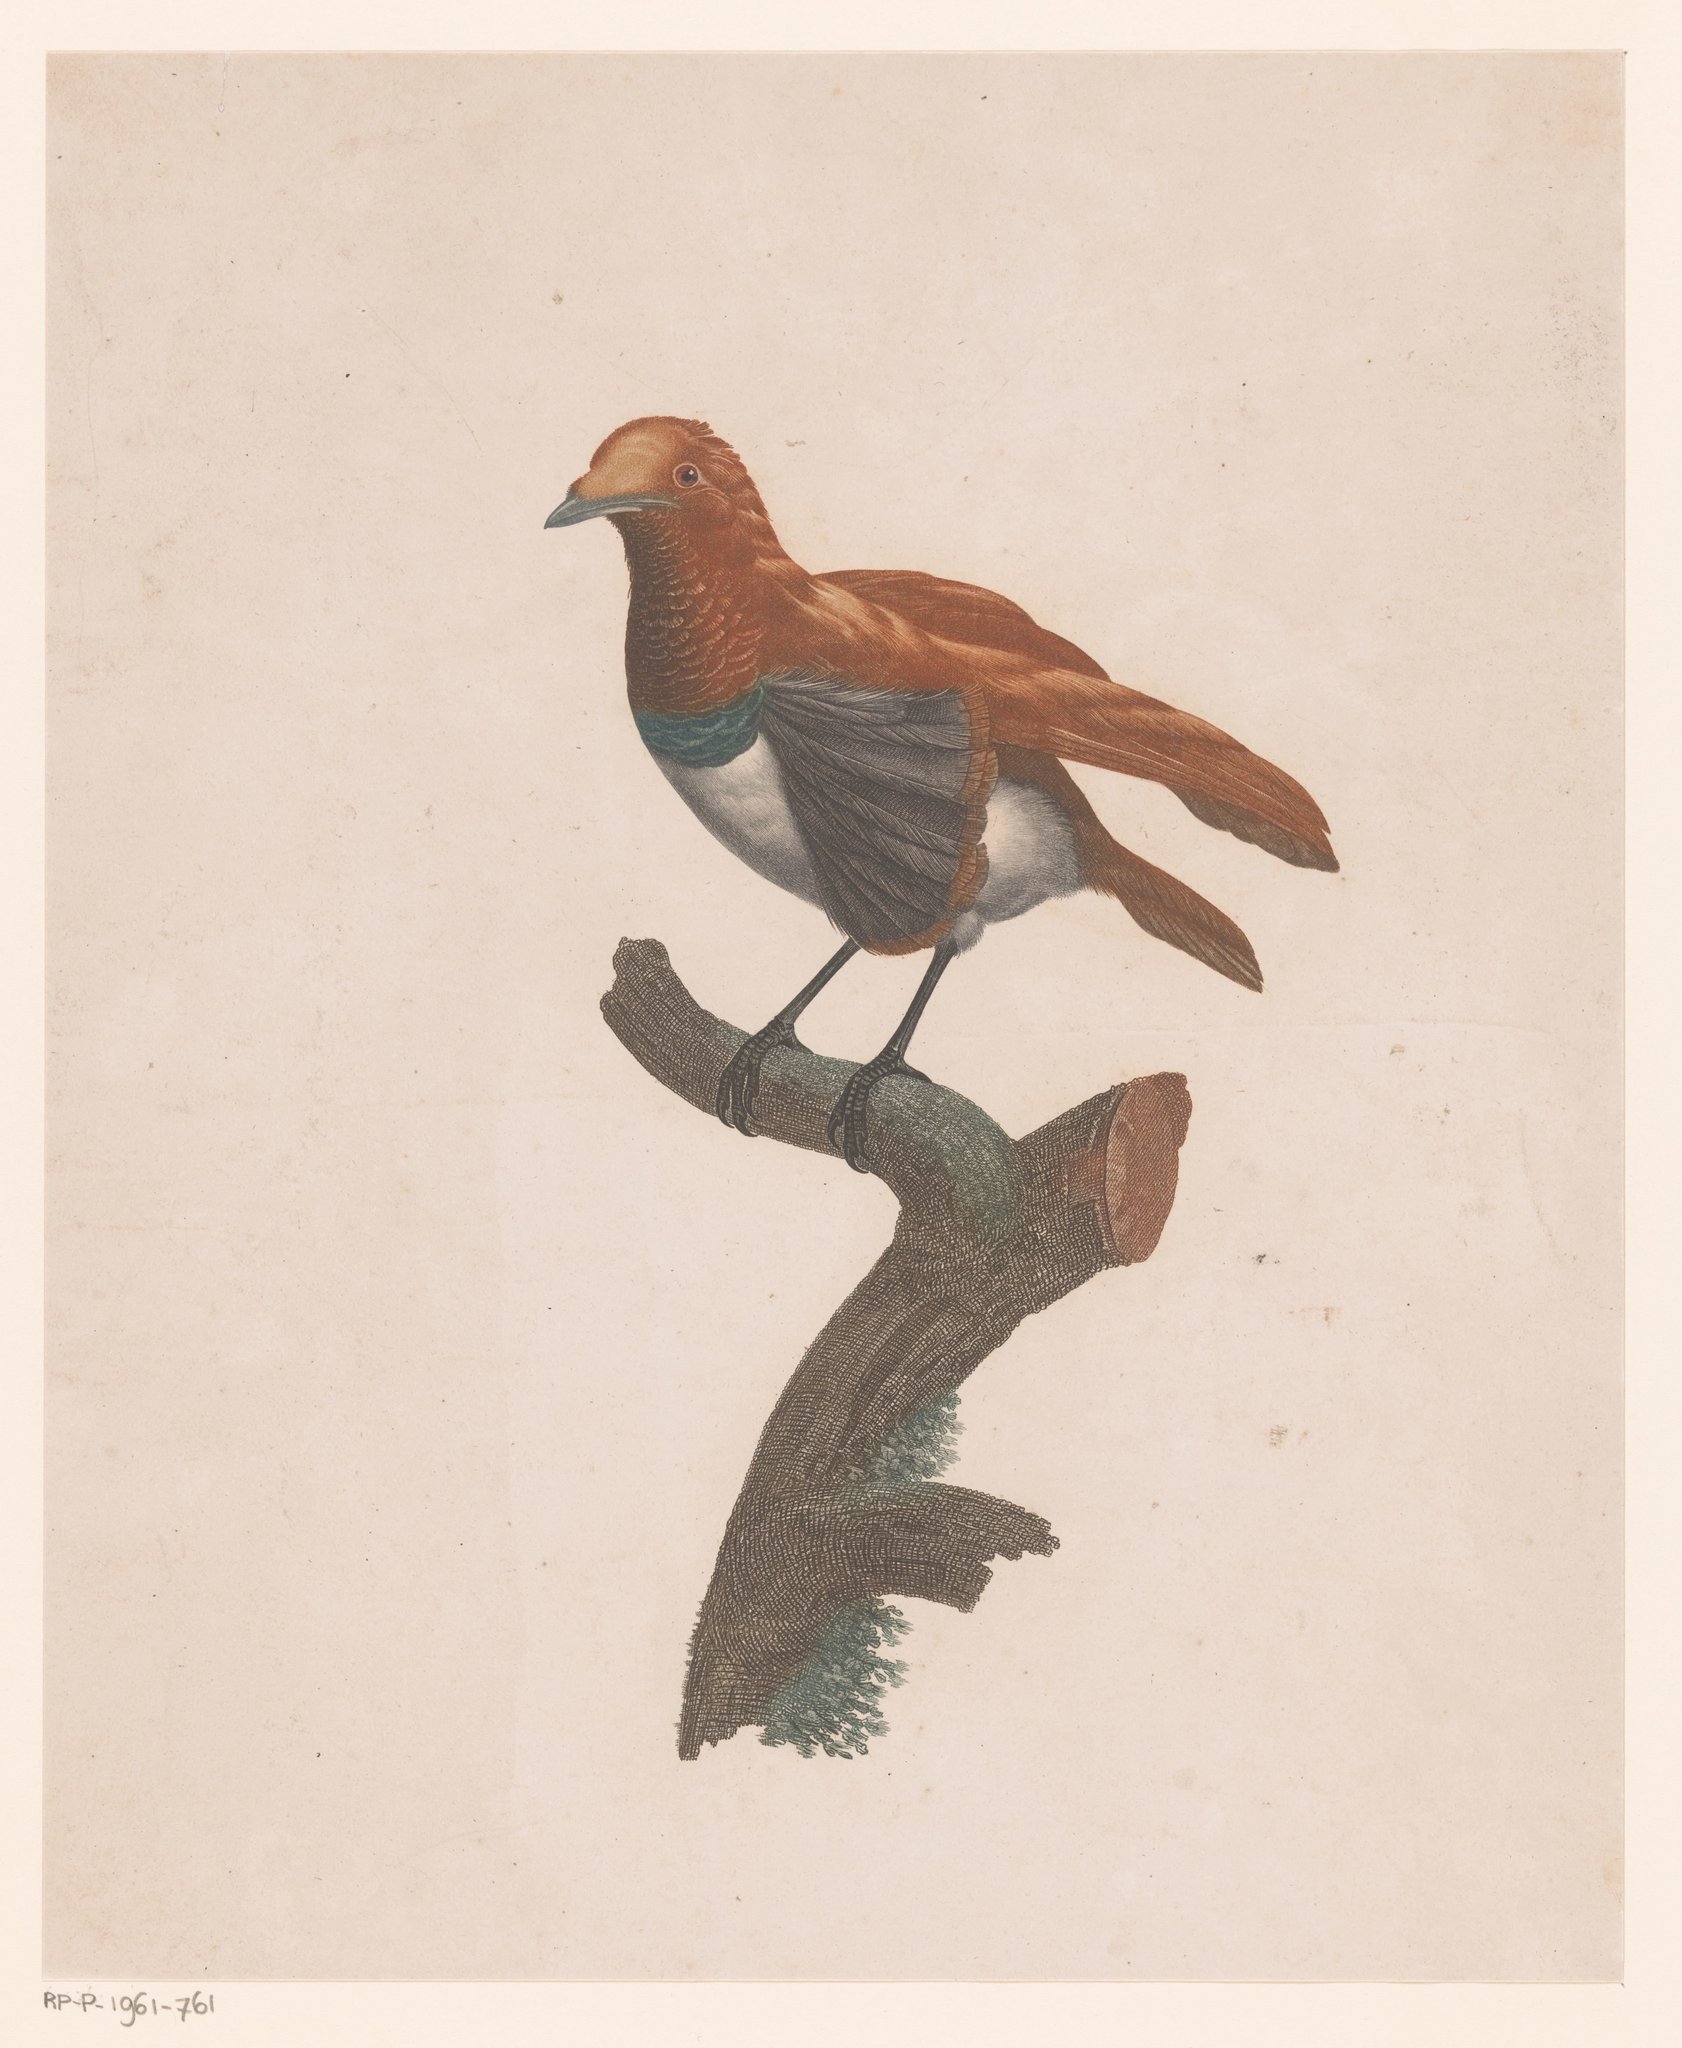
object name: book illustration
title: Vogel op een tak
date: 1801-1806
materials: paper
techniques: engraving, etching, lithography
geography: paris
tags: birds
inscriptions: collector's mark: ‘School voor de grafische vakken te Utrecht’, collector's mark: Lugt 2228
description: Prent uit: Levaillant, François. Histoire naturelle des oiseaux de paradis et des rolliers (...). Parijs: Denné le Jeune en Perlet, 1801-1806.